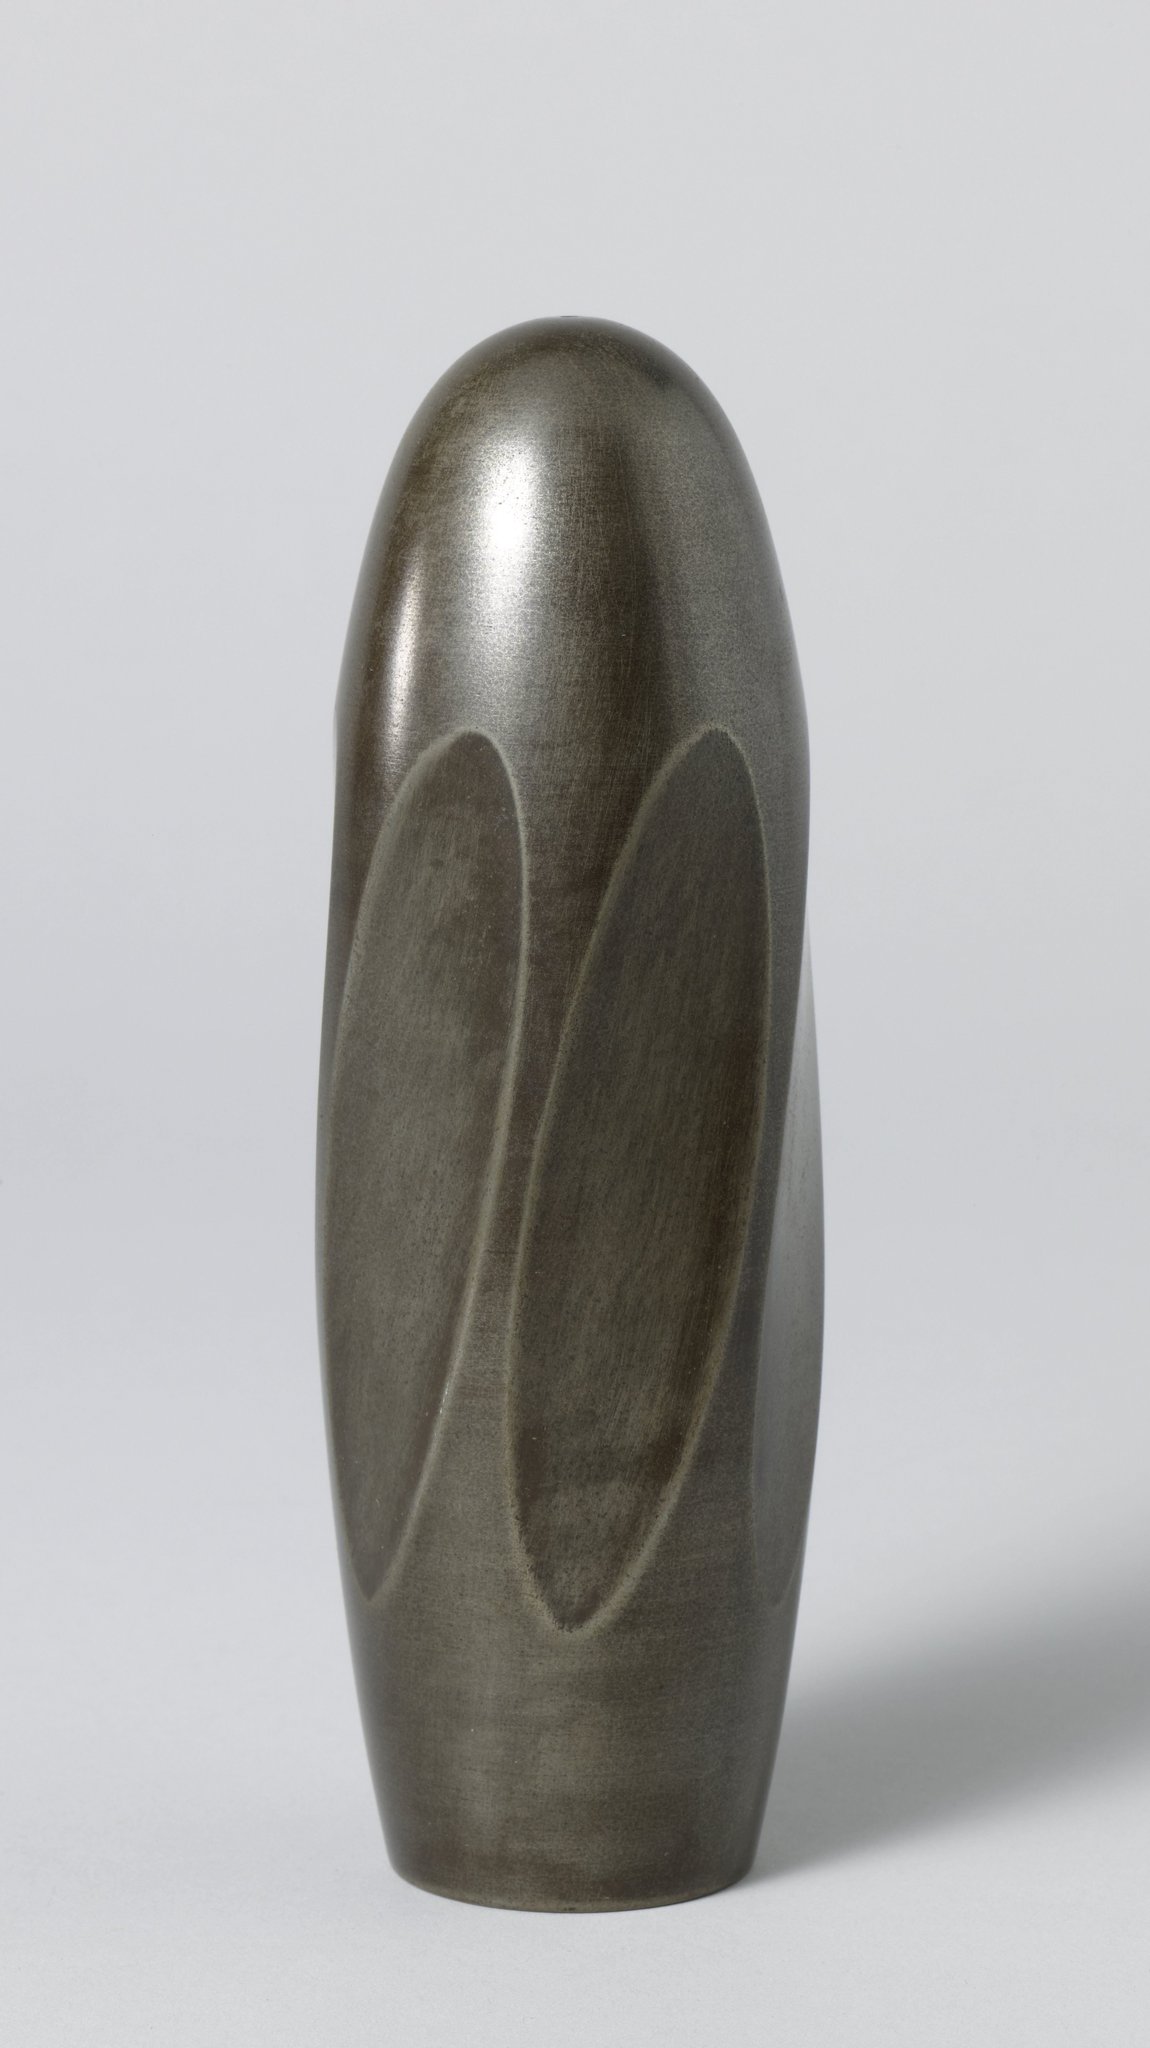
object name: grenade ammunition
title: Six-Pounder Shot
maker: joseph whitworth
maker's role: manufacturer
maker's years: 1803-1887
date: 1861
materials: iron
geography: manchester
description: De ronde punt wijst op een gebruik op langere afstand en niet voor gepantserde doelen.